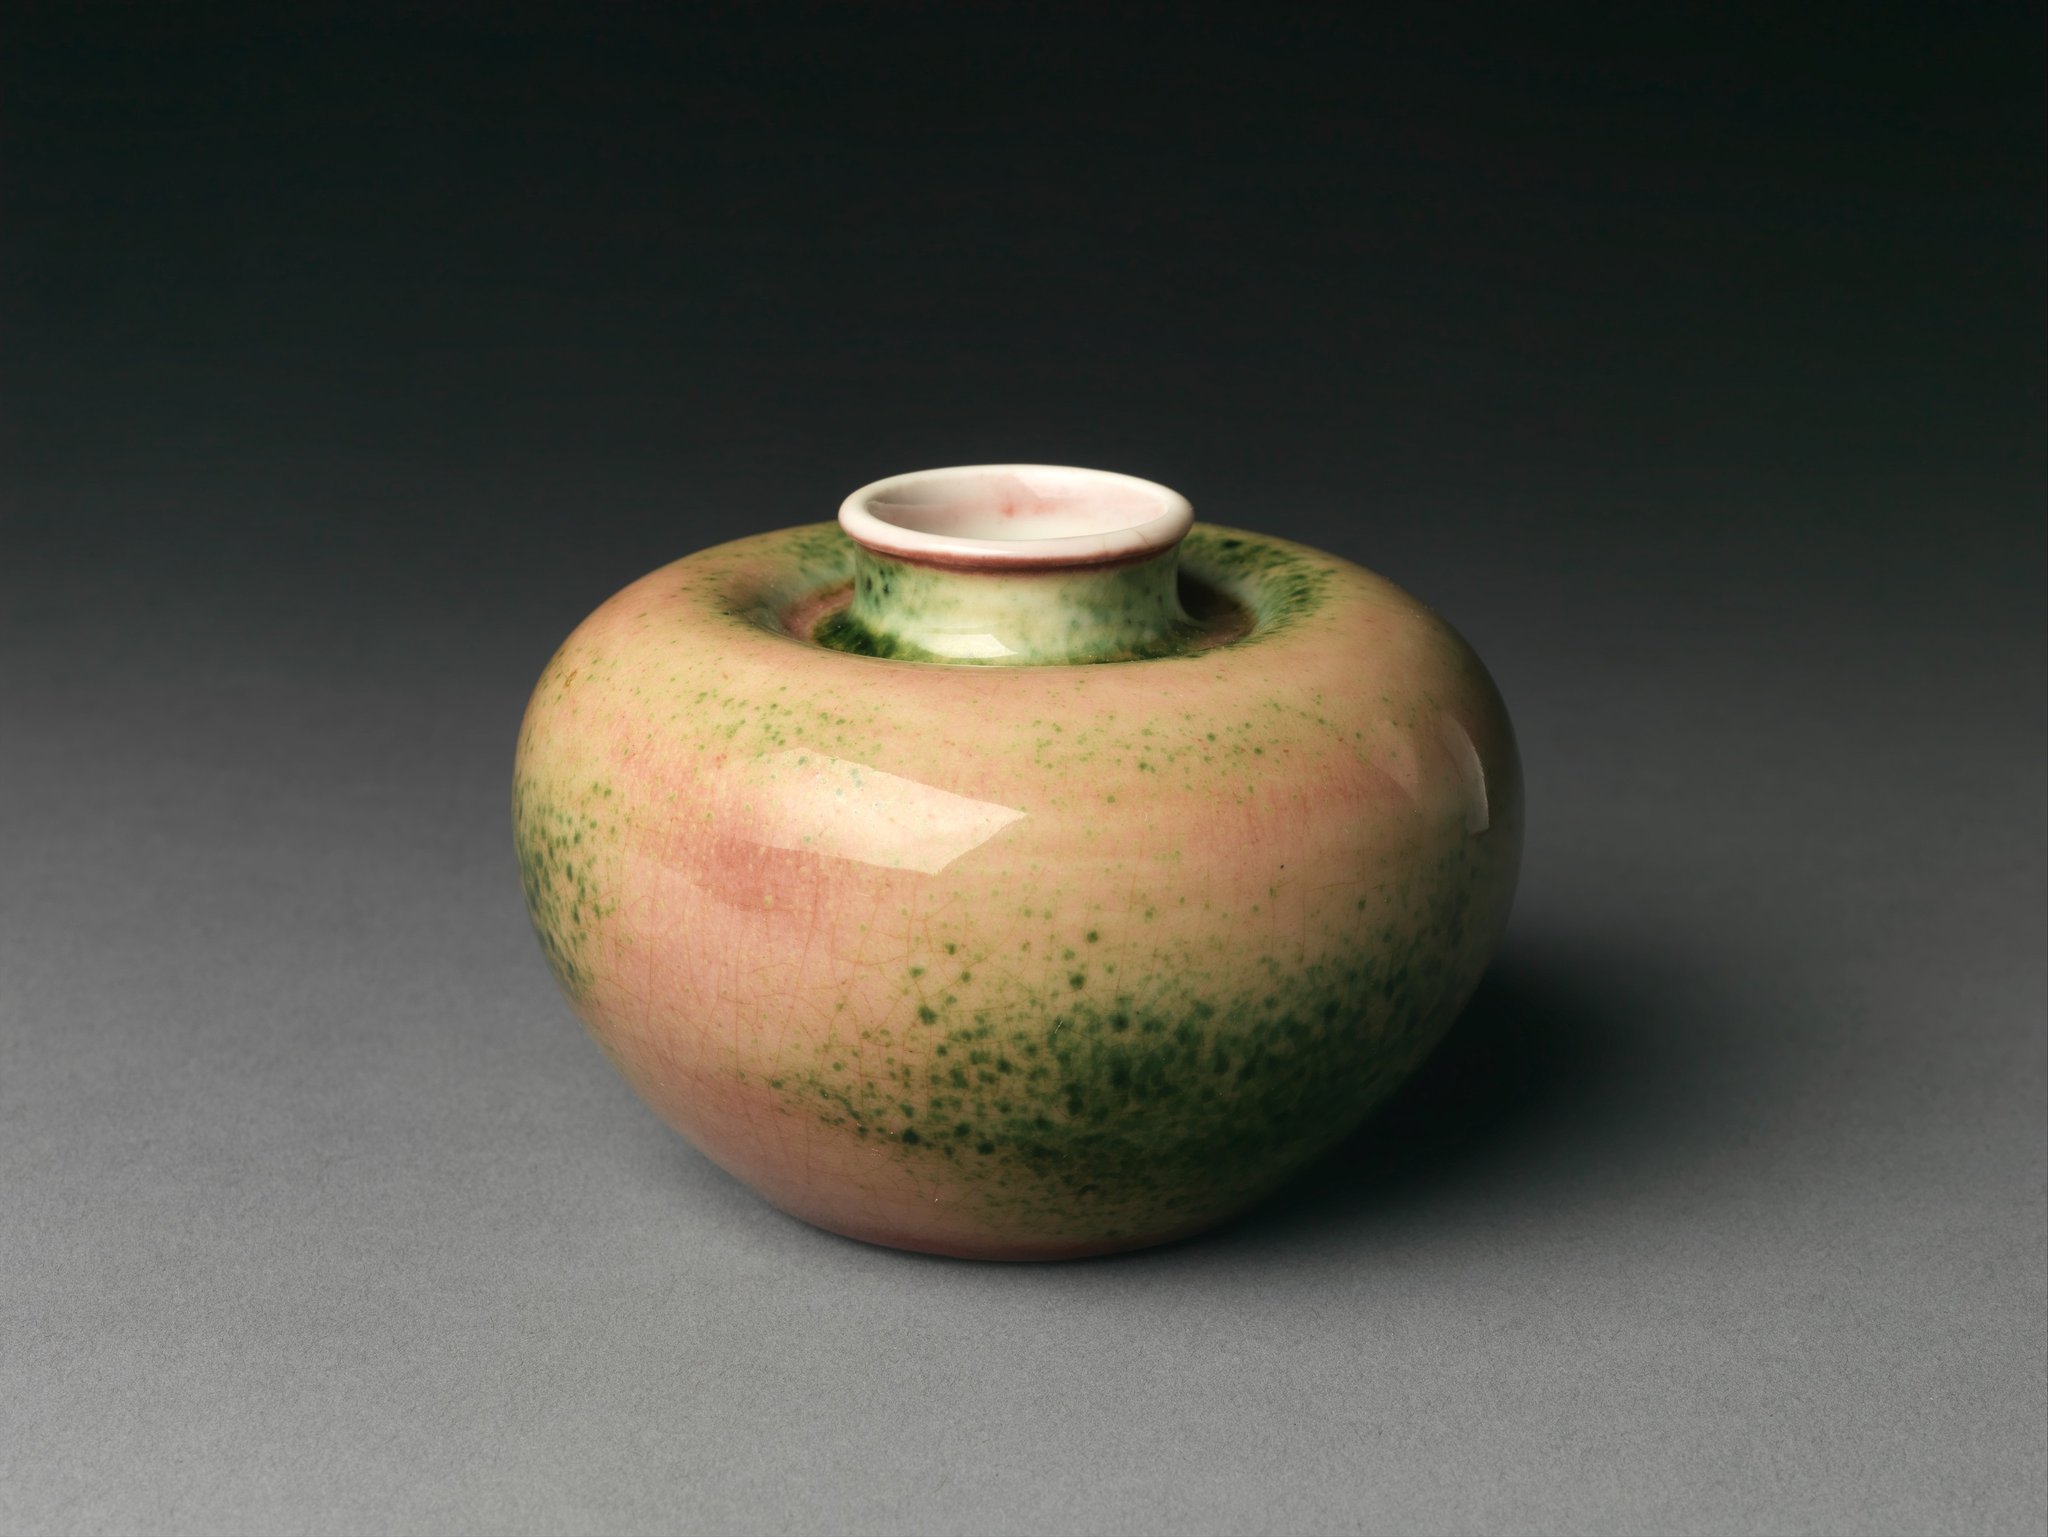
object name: jar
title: Water Jar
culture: chinese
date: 1678-1688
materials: glaze, porcelain